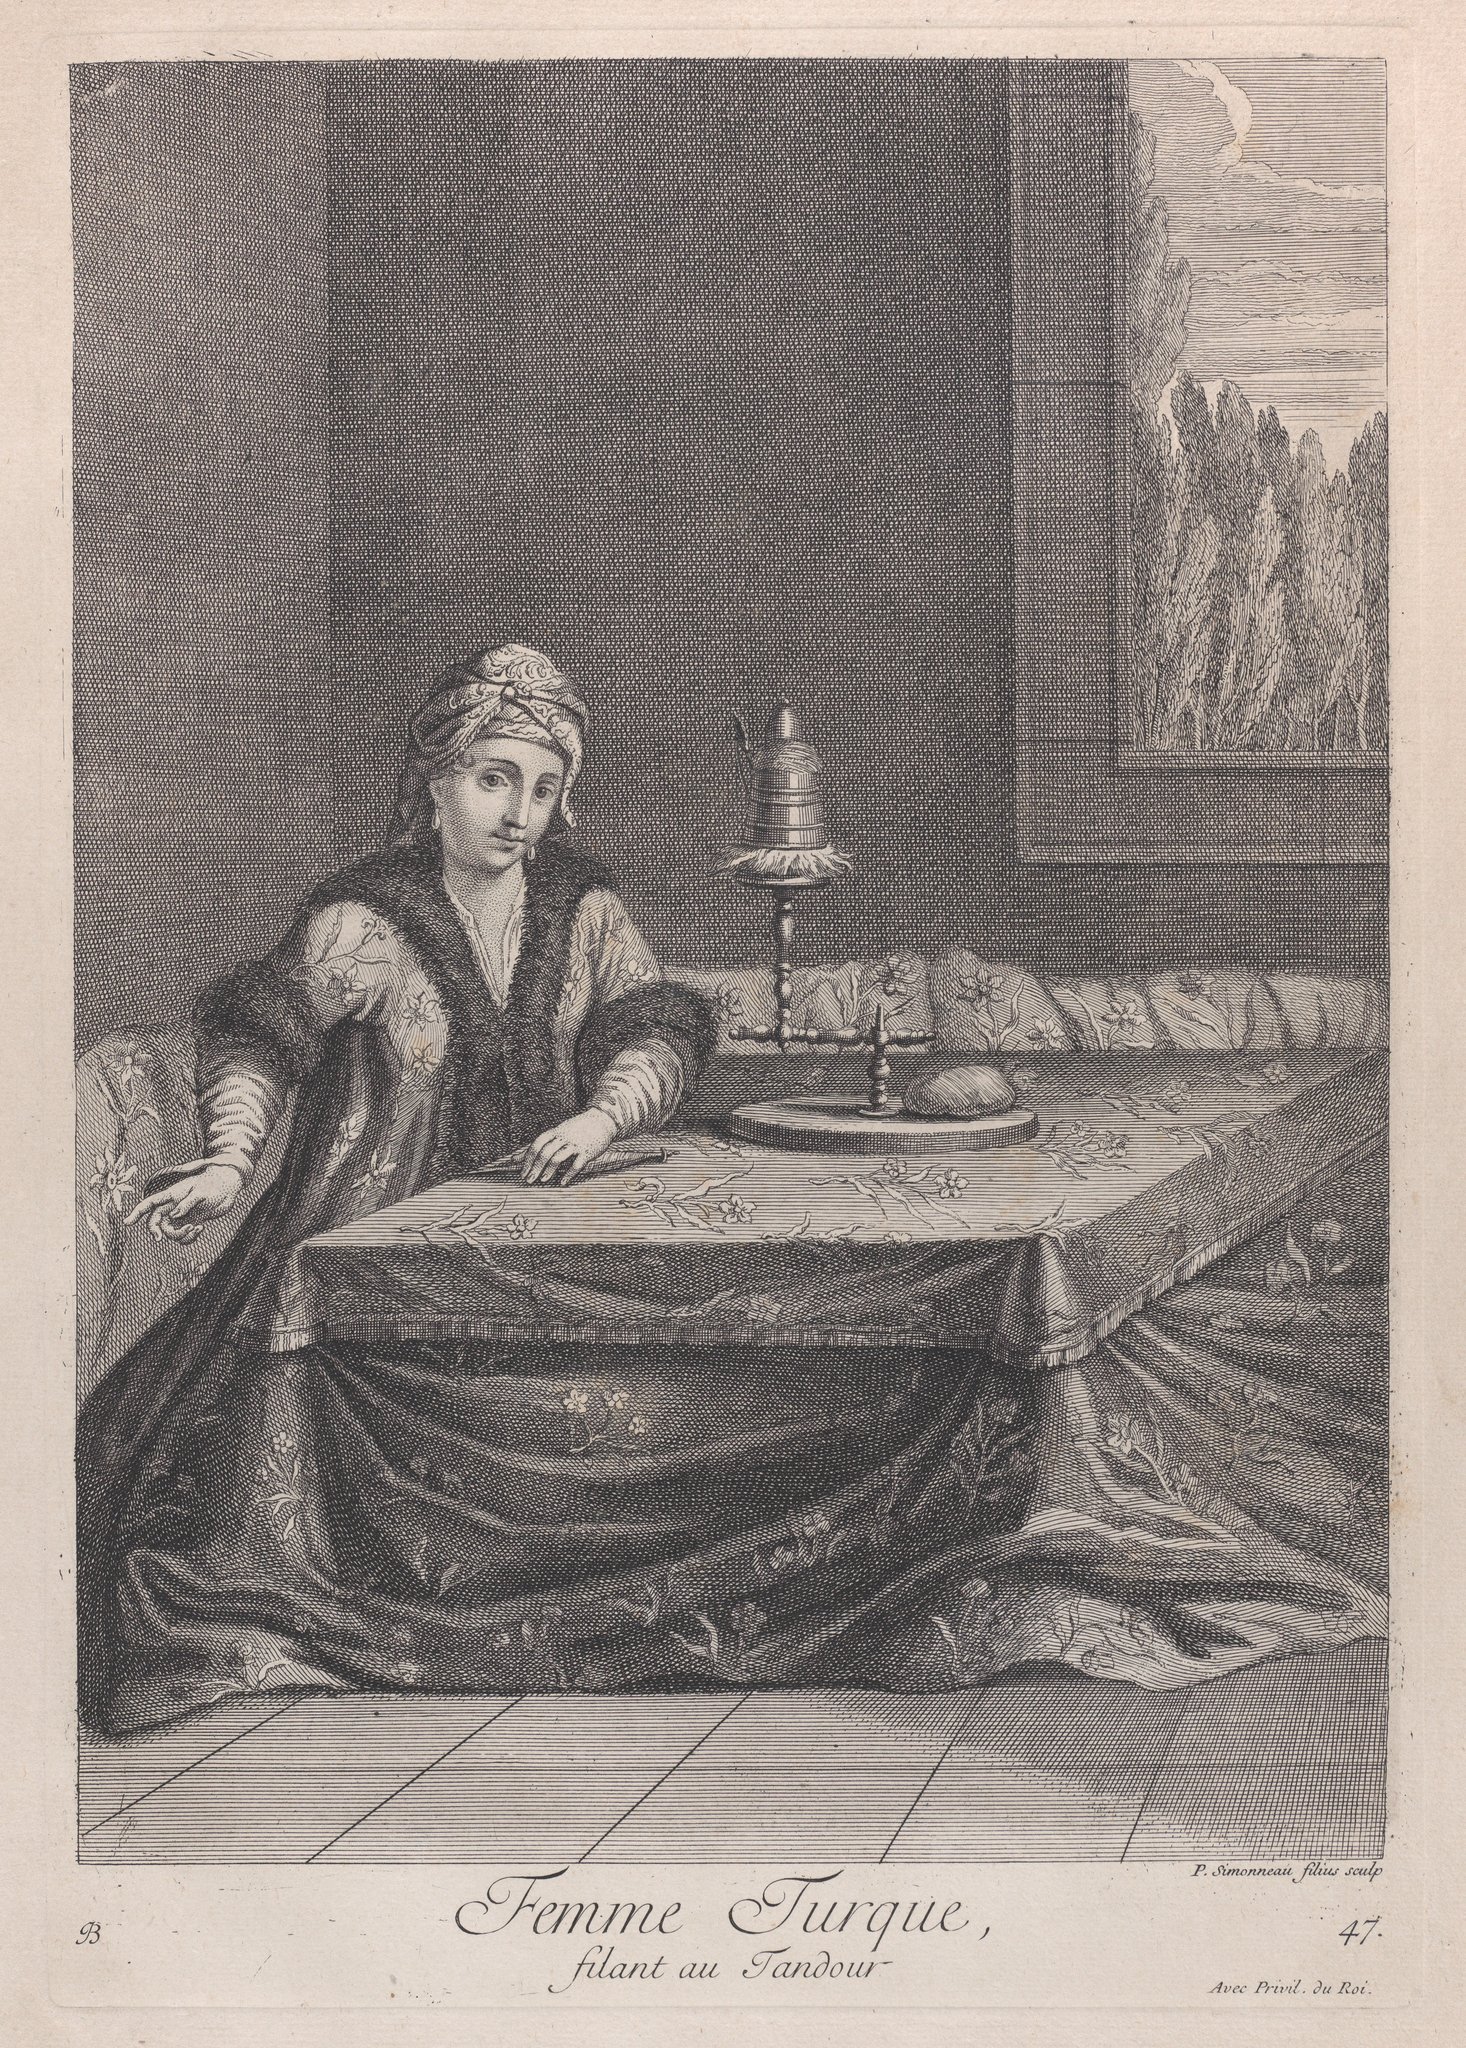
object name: print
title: Femme Turque, filant au Tandour, plate 47 from "Recueil de cent estampes représentent differentes nations du Levant"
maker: jean baptiste vanmour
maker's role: artist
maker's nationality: french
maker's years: 1671-1737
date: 1714-1715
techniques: engraving, etching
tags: women